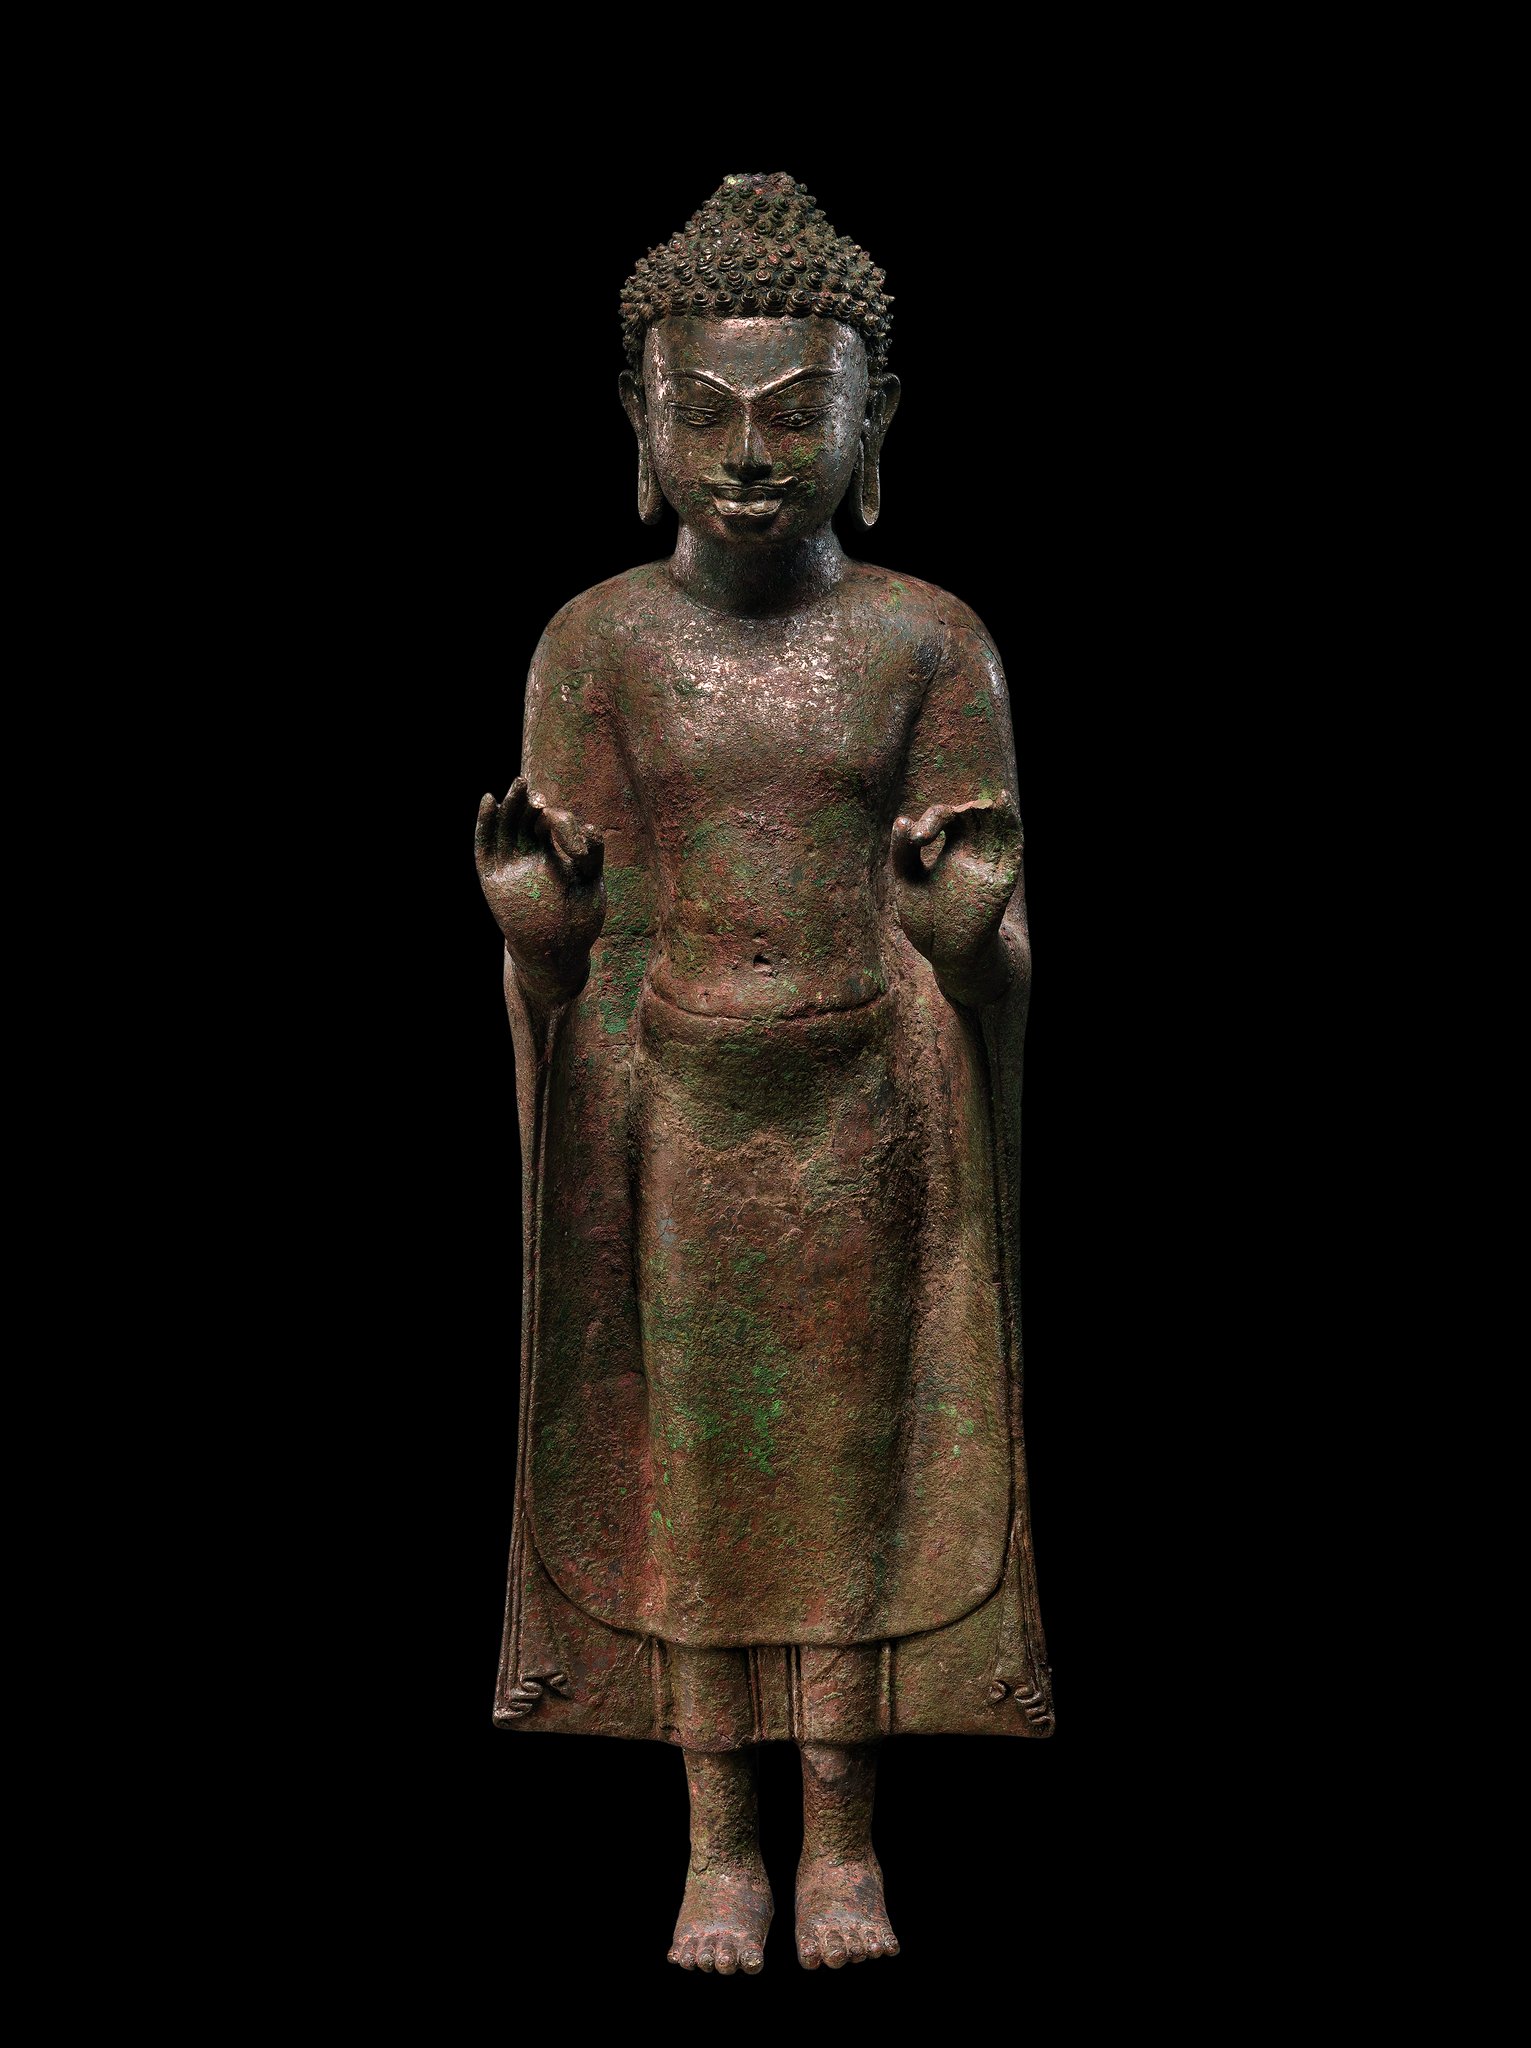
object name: figure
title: Buddha Preaching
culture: thailand, buriram province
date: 701-800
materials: copper alloy, glass, obsidian, silver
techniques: inlay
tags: buddhism,buddha